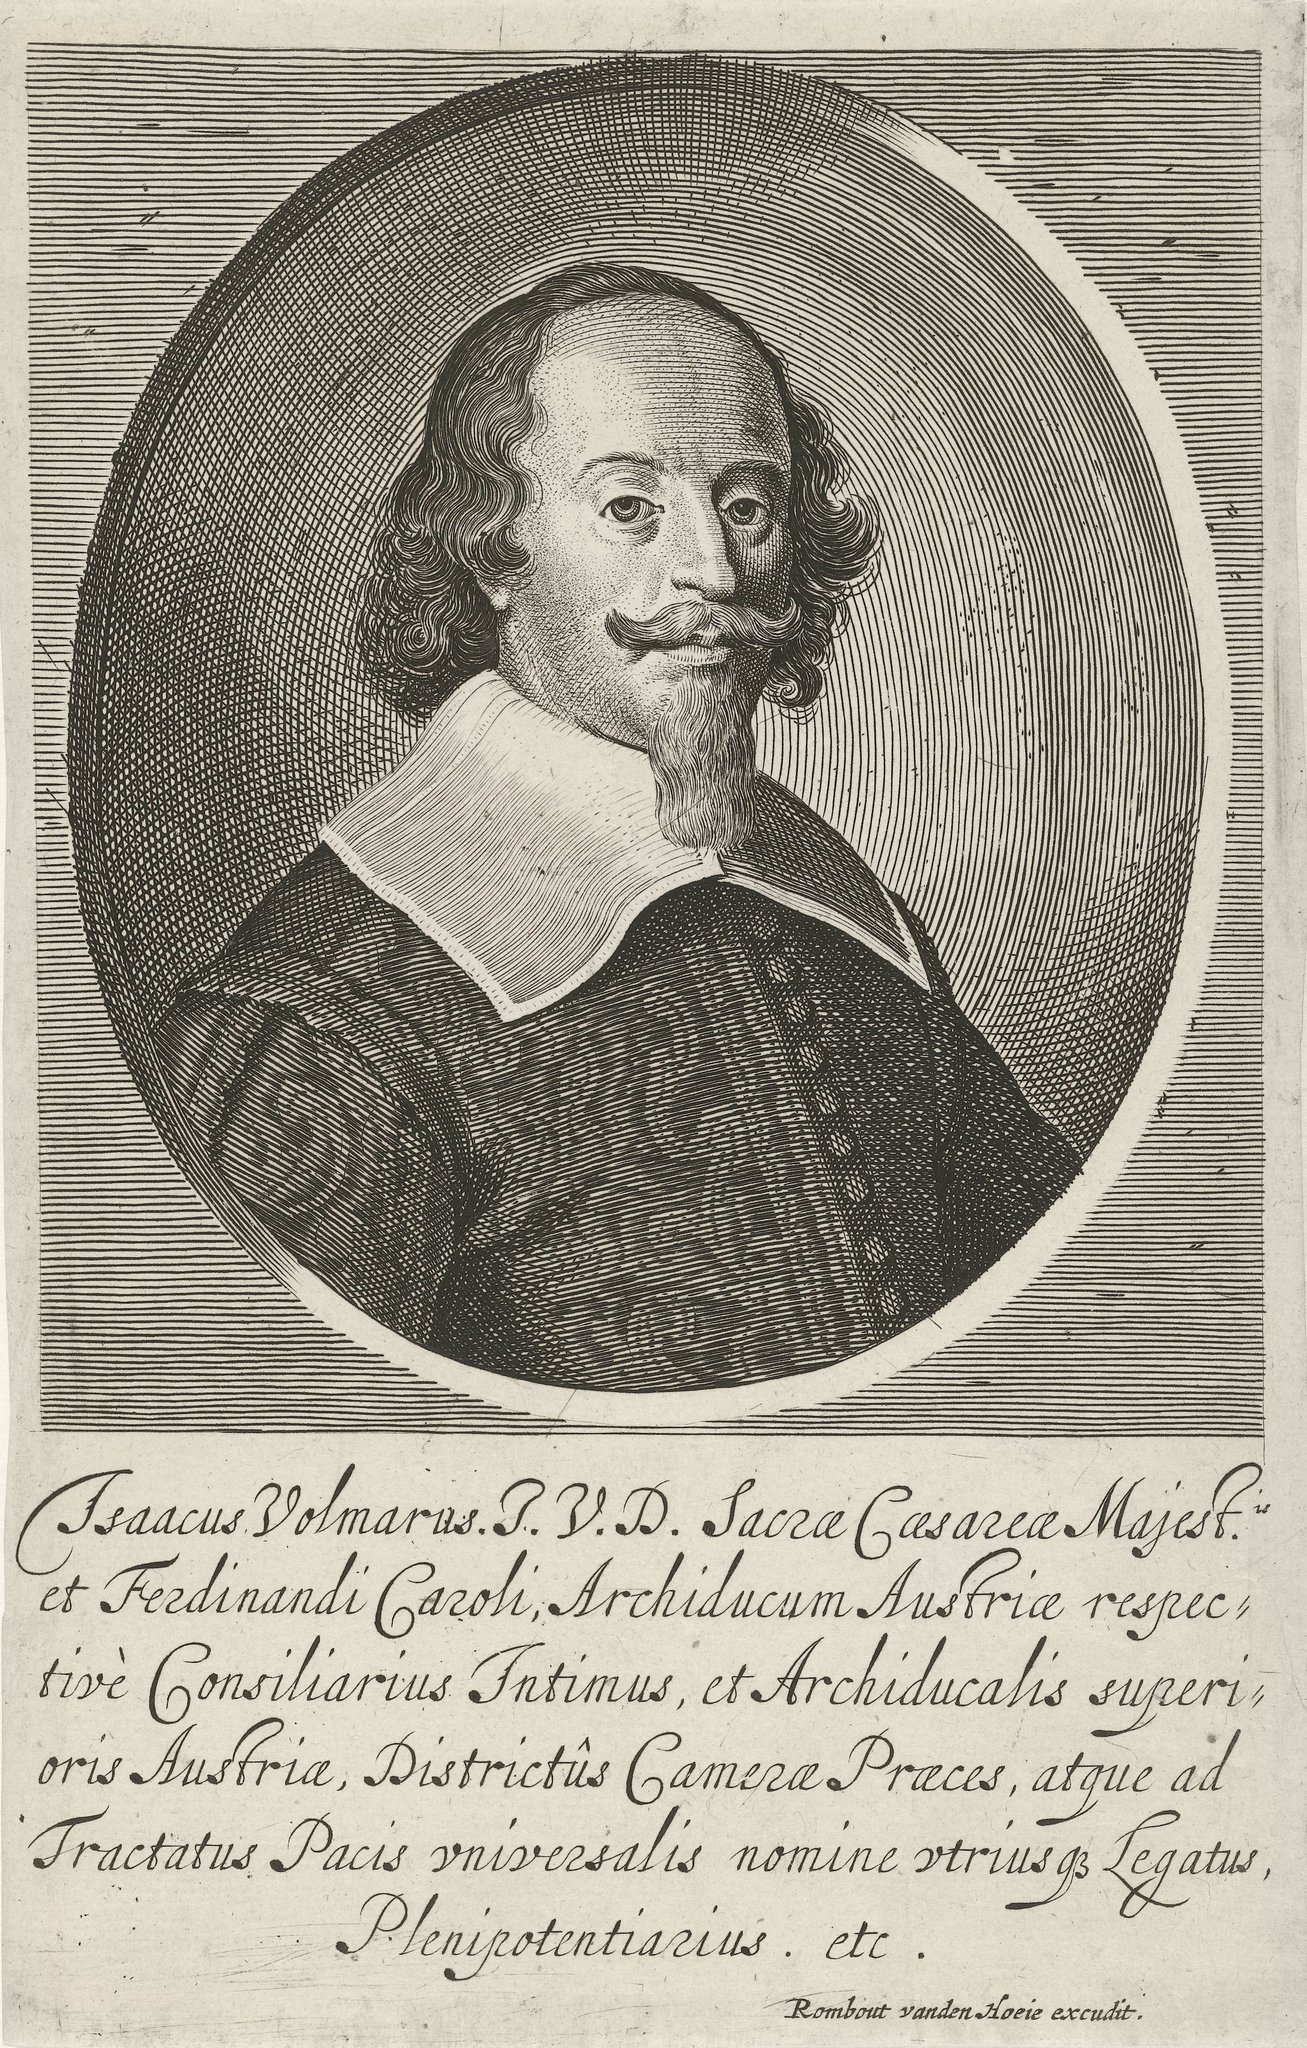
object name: print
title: Portret van Isaak Volmar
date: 1644-1664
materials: paper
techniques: engraving, etching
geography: amsterdam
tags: isaak volmar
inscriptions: collector's mark: Lugt 2228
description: Portret van Isaak Volmar, onderhandelaar bij de Vrede van Westfalen. Buste naar links in een ovaal. Onderaan in de marge een zesregelige tekst in het Latijn.